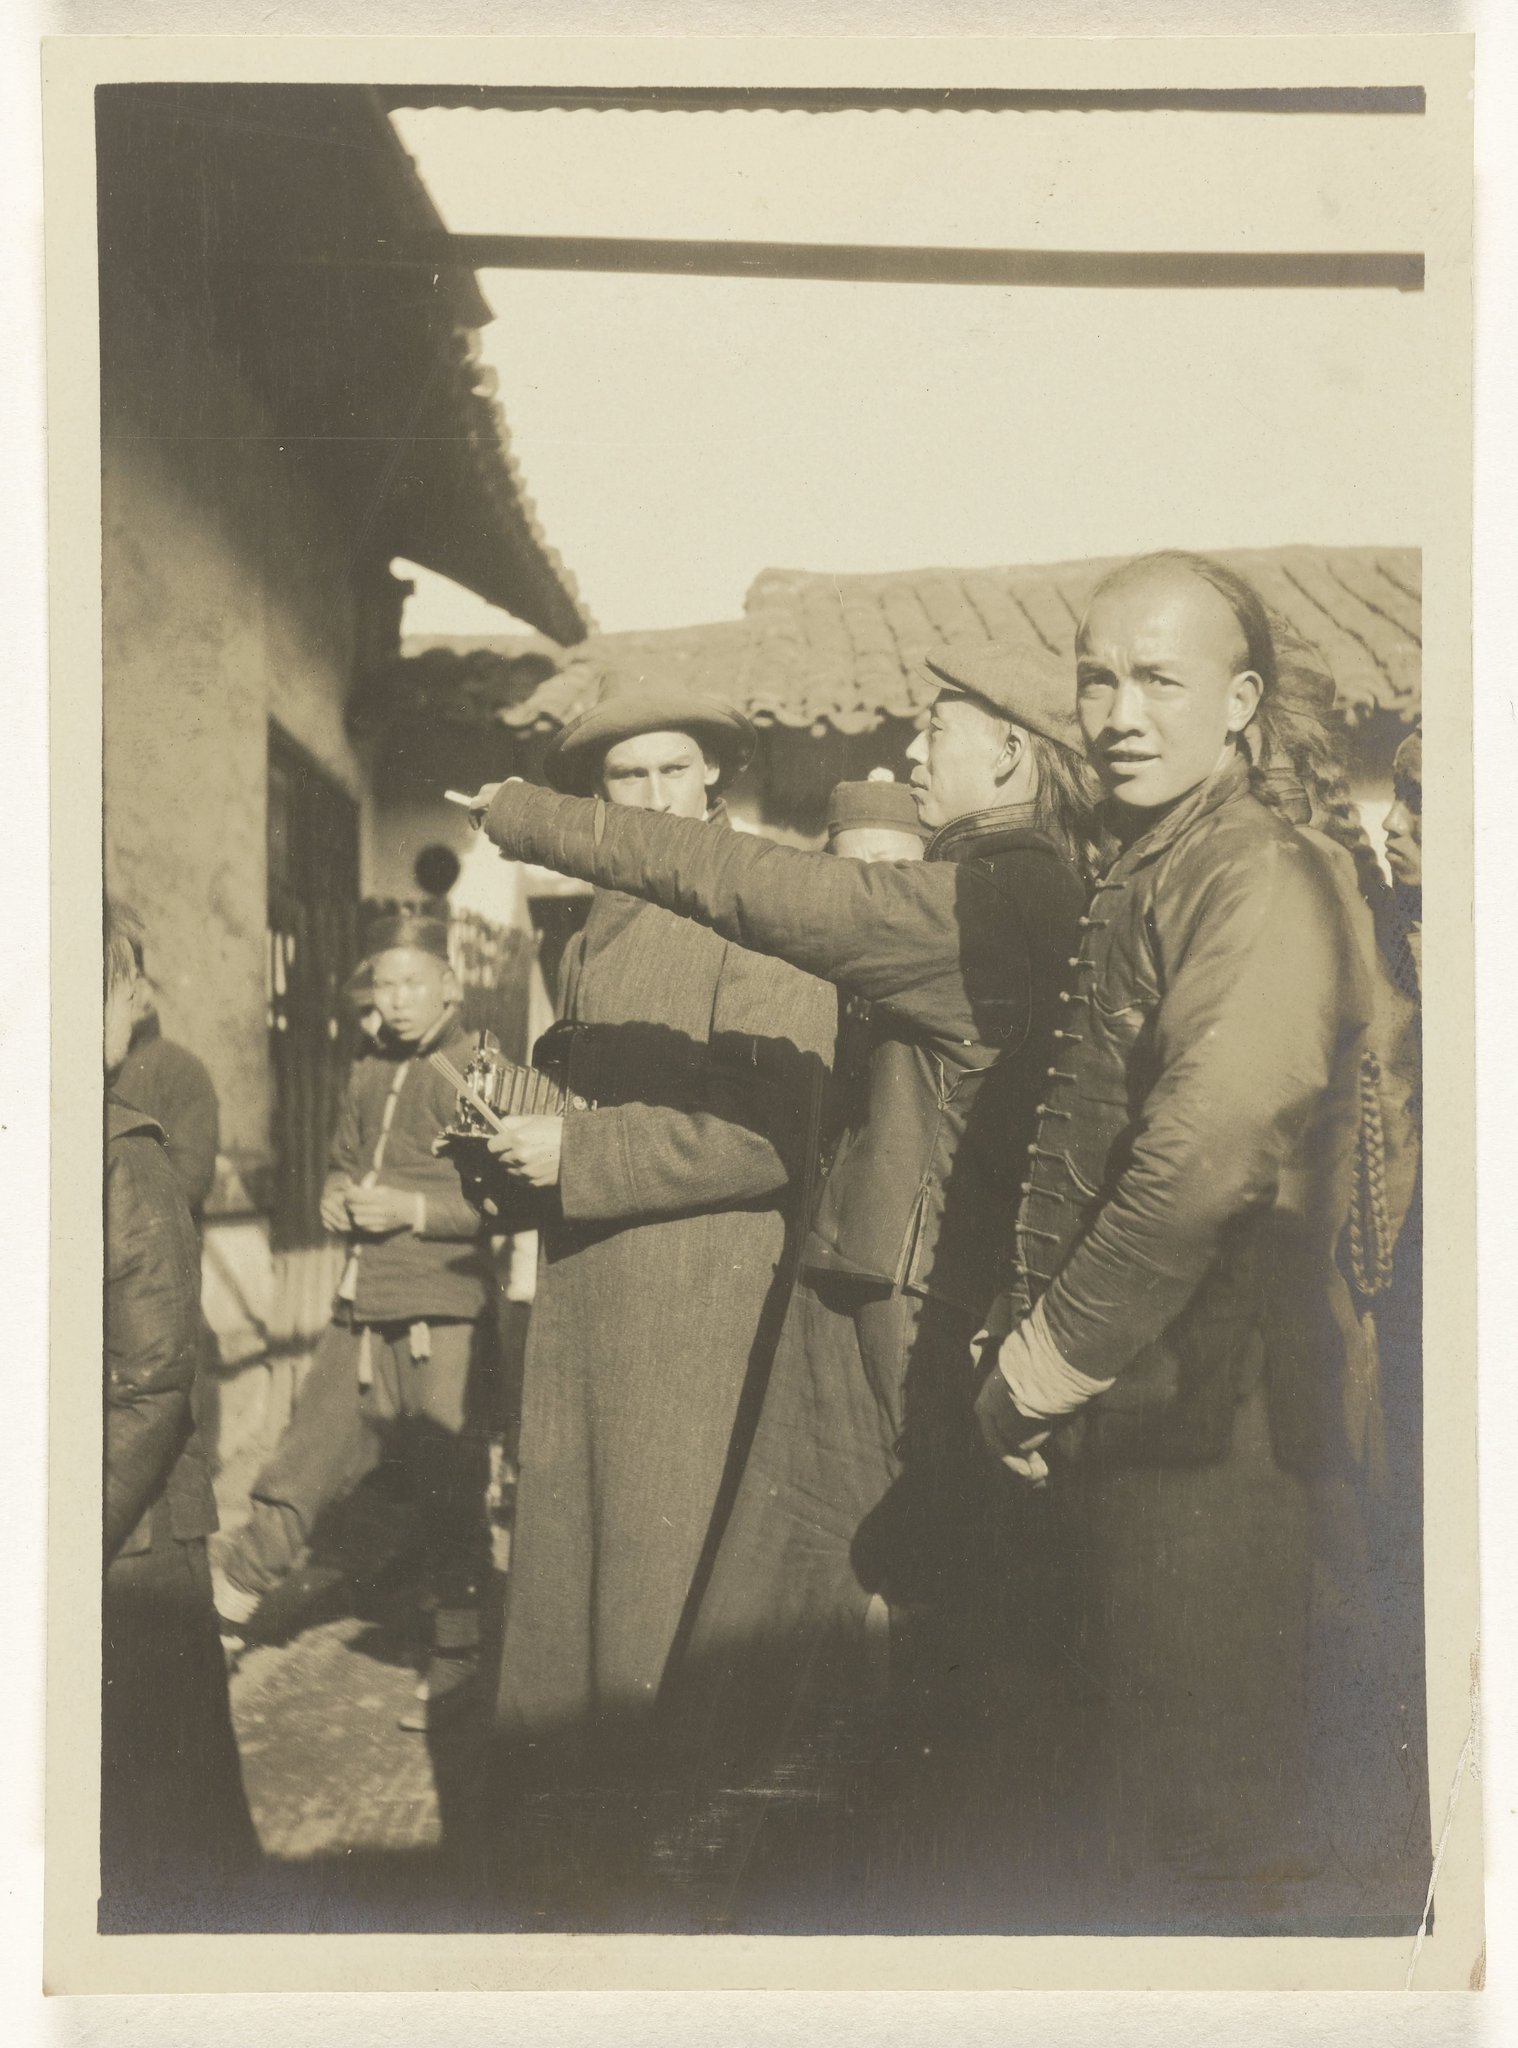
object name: photograph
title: Chinese people and a travelling companion in Shanghai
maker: geldolph adriaan kessler (dolph)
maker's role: fotograaf, industrieel, voetballer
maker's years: 1884-1945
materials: cardboard, photographic support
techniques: gelatin silver print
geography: netherlands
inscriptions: title: ‘Amongst the masks’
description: Tussen de menigte op straat in Shanghai staat een reisgenoot van Dolph Kessler met een camera. Onderdeel van het fotoalbum van Dolph Kessler met opnamen die hij maakte tijdens zijn verblijf in Engeland en op een wereldreis die hij als secretaris van Henri Deterding (directeur Koninklijke Olie) ondernam naar Nederlands-Indië, Japan, China en de Verenigde Staten, tussen 1906 en 1908.